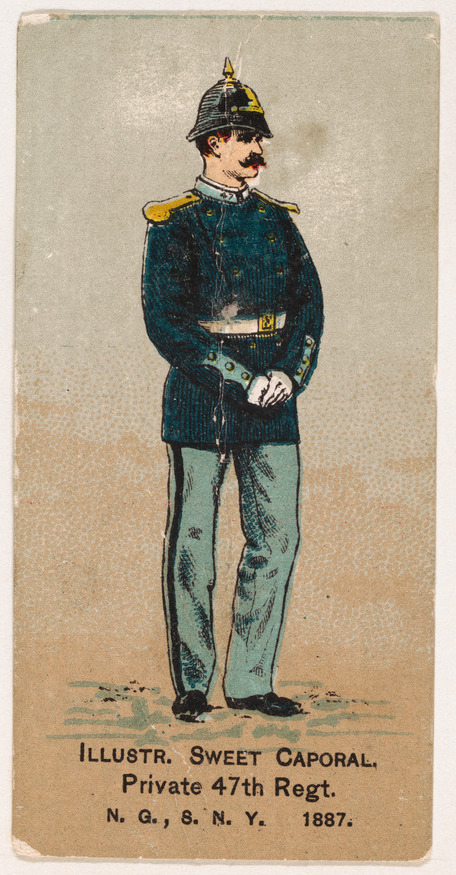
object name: print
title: Private, 47th Regiment, National Guard of the State of New York, from the Military Series (N224) issued by Kinney Tobacco Company to promote Sweet Caporal Cigarettes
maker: kinney brothers tobacco company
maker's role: publisher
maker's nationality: american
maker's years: 1869-2011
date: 1888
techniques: color lithograph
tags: military,men,profiles